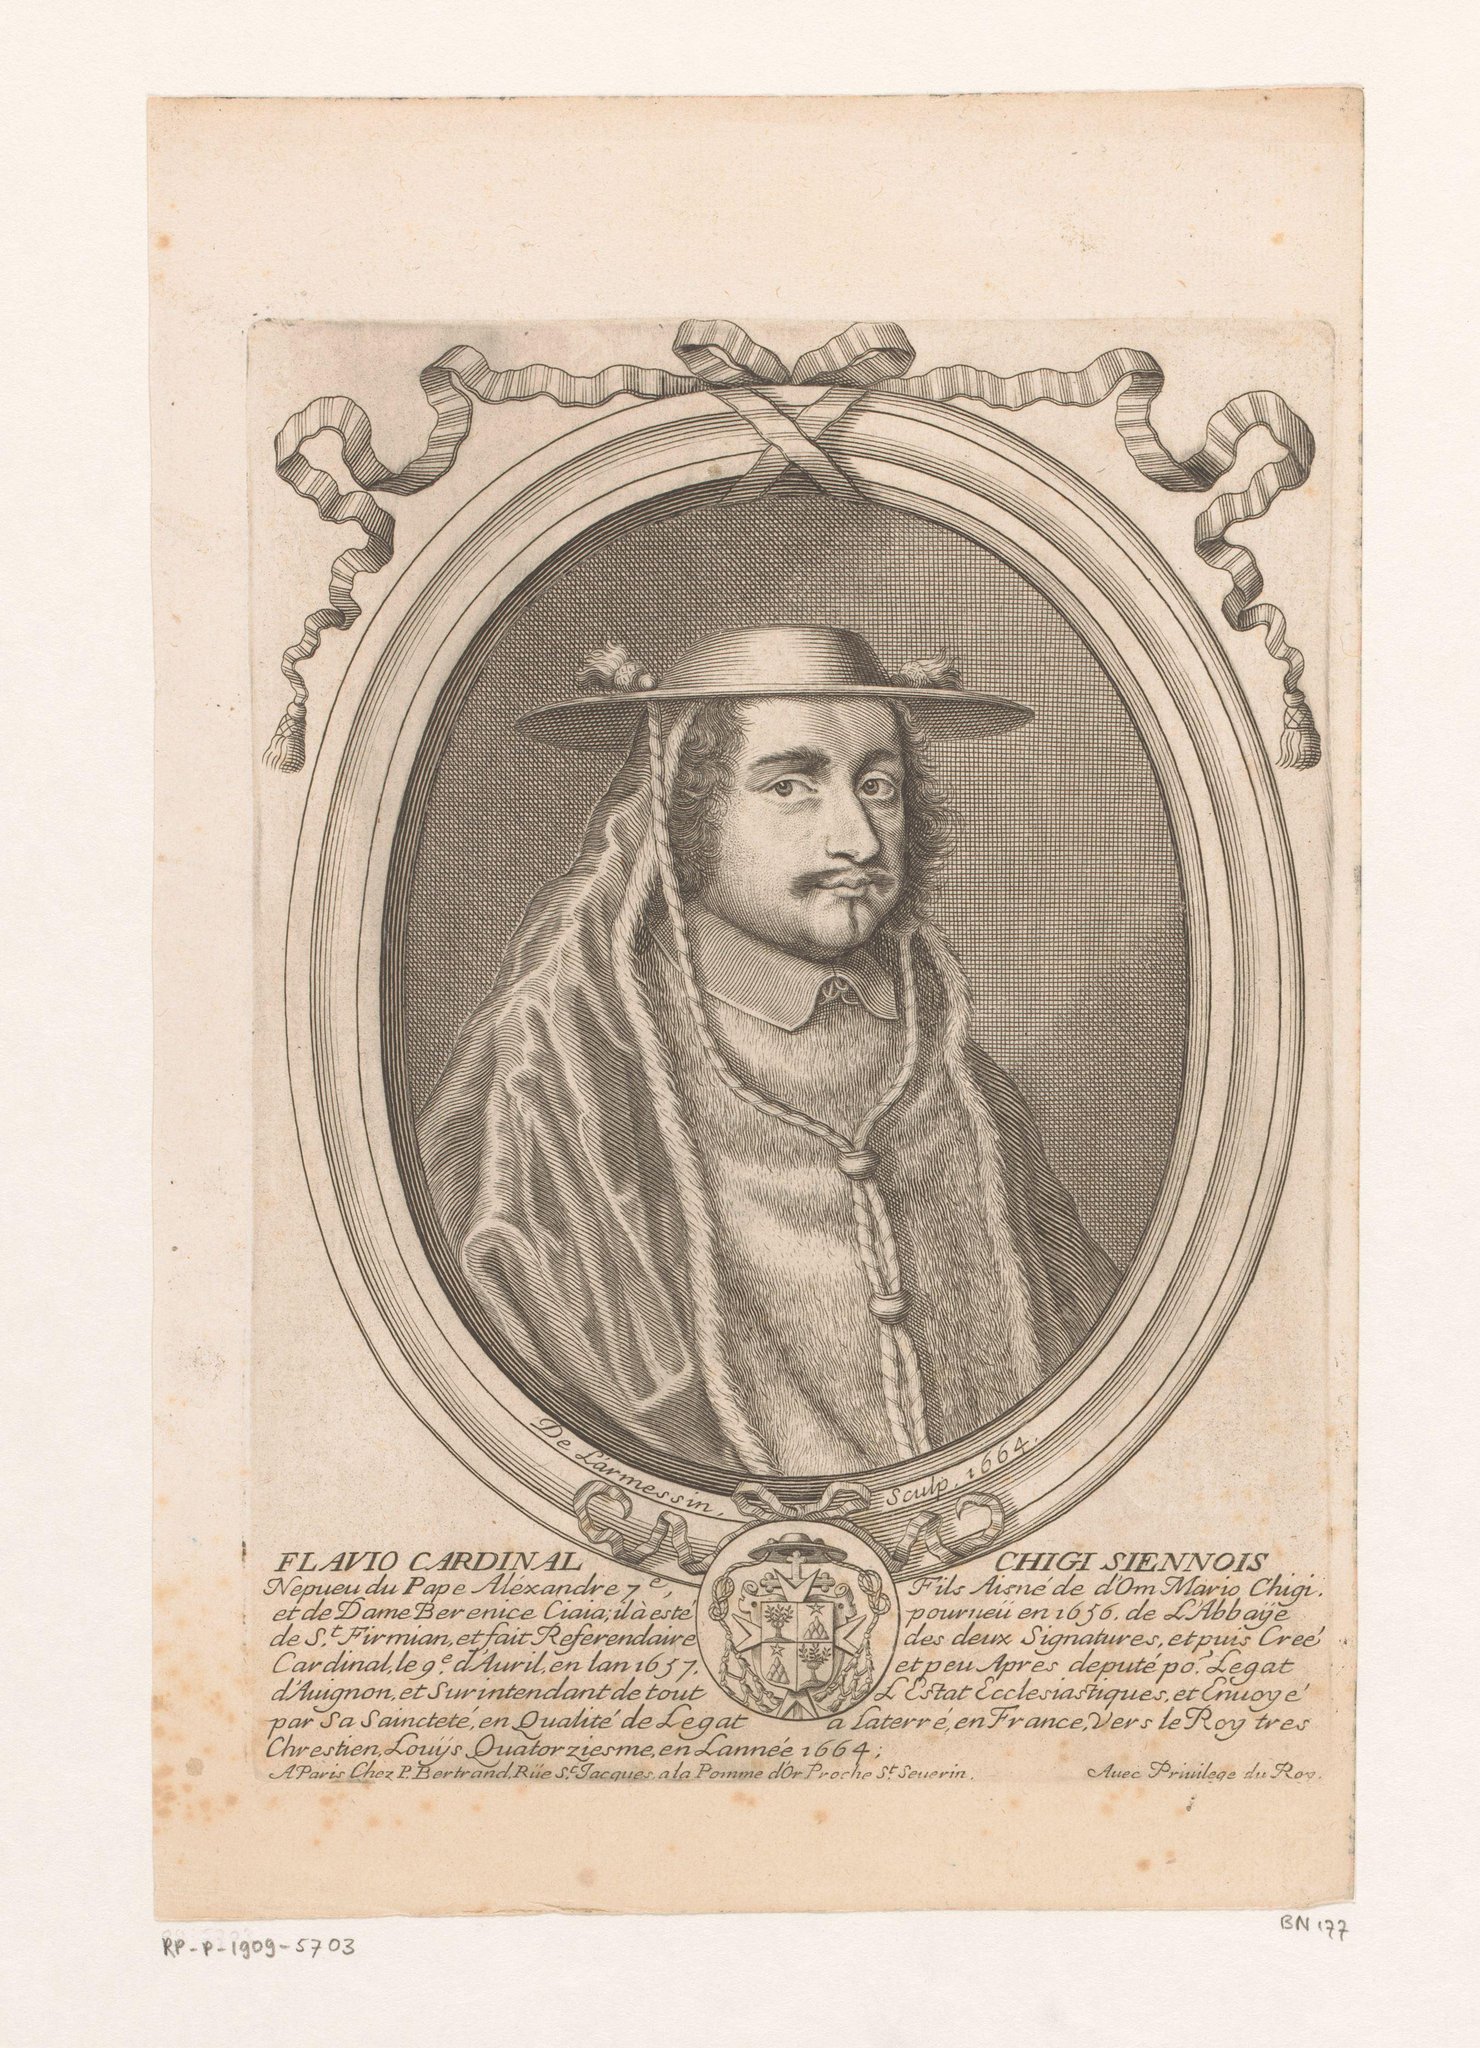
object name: print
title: Portret van Flavio Chigi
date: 1664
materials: paper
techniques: engraving, etching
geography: france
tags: rome, flavio chigi, cardinal, historical persons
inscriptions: collector's mark: Lugt 2228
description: Maakt deel uit van een grootschalige serie met portretten van prominente figuren. Binnen de serie bevindt zich een sectie getiteld 'Les Augustes Représentations De tous les Roys De France depuis Pharamond Iusqu'à Louys XIIII'. De serie werd respectievelijk uitgegeven door Pierre Bertrand, door zijn weduwe en door De Larmessin zelf.